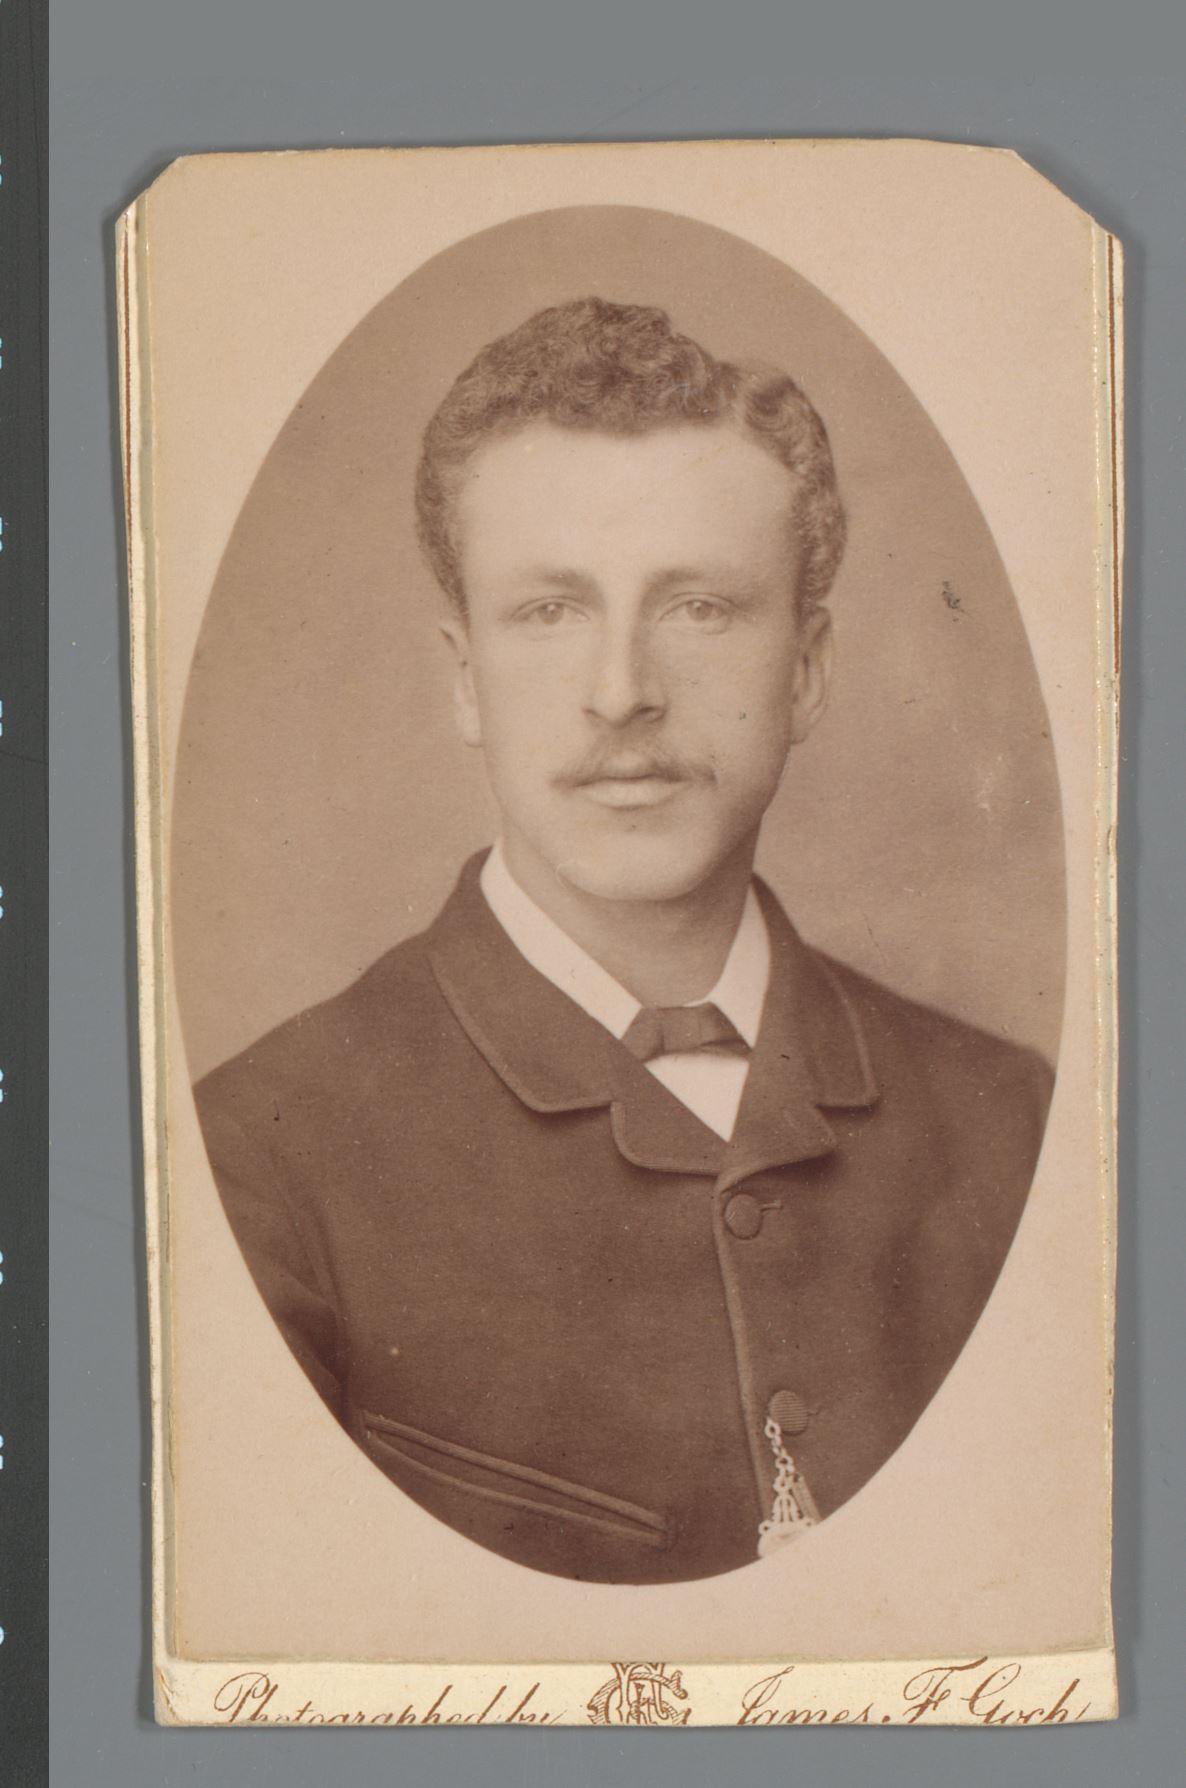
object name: carte de visite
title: Portret van Willem Jacobus Fockens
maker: james f. goch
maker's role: fotograaf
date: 1875-1899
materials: cardboard, photographic support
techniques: collodion silver print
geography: johannesburg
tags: historical persons, johannesburg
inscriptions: name: ‘Willem Fockens’, workshop stamp